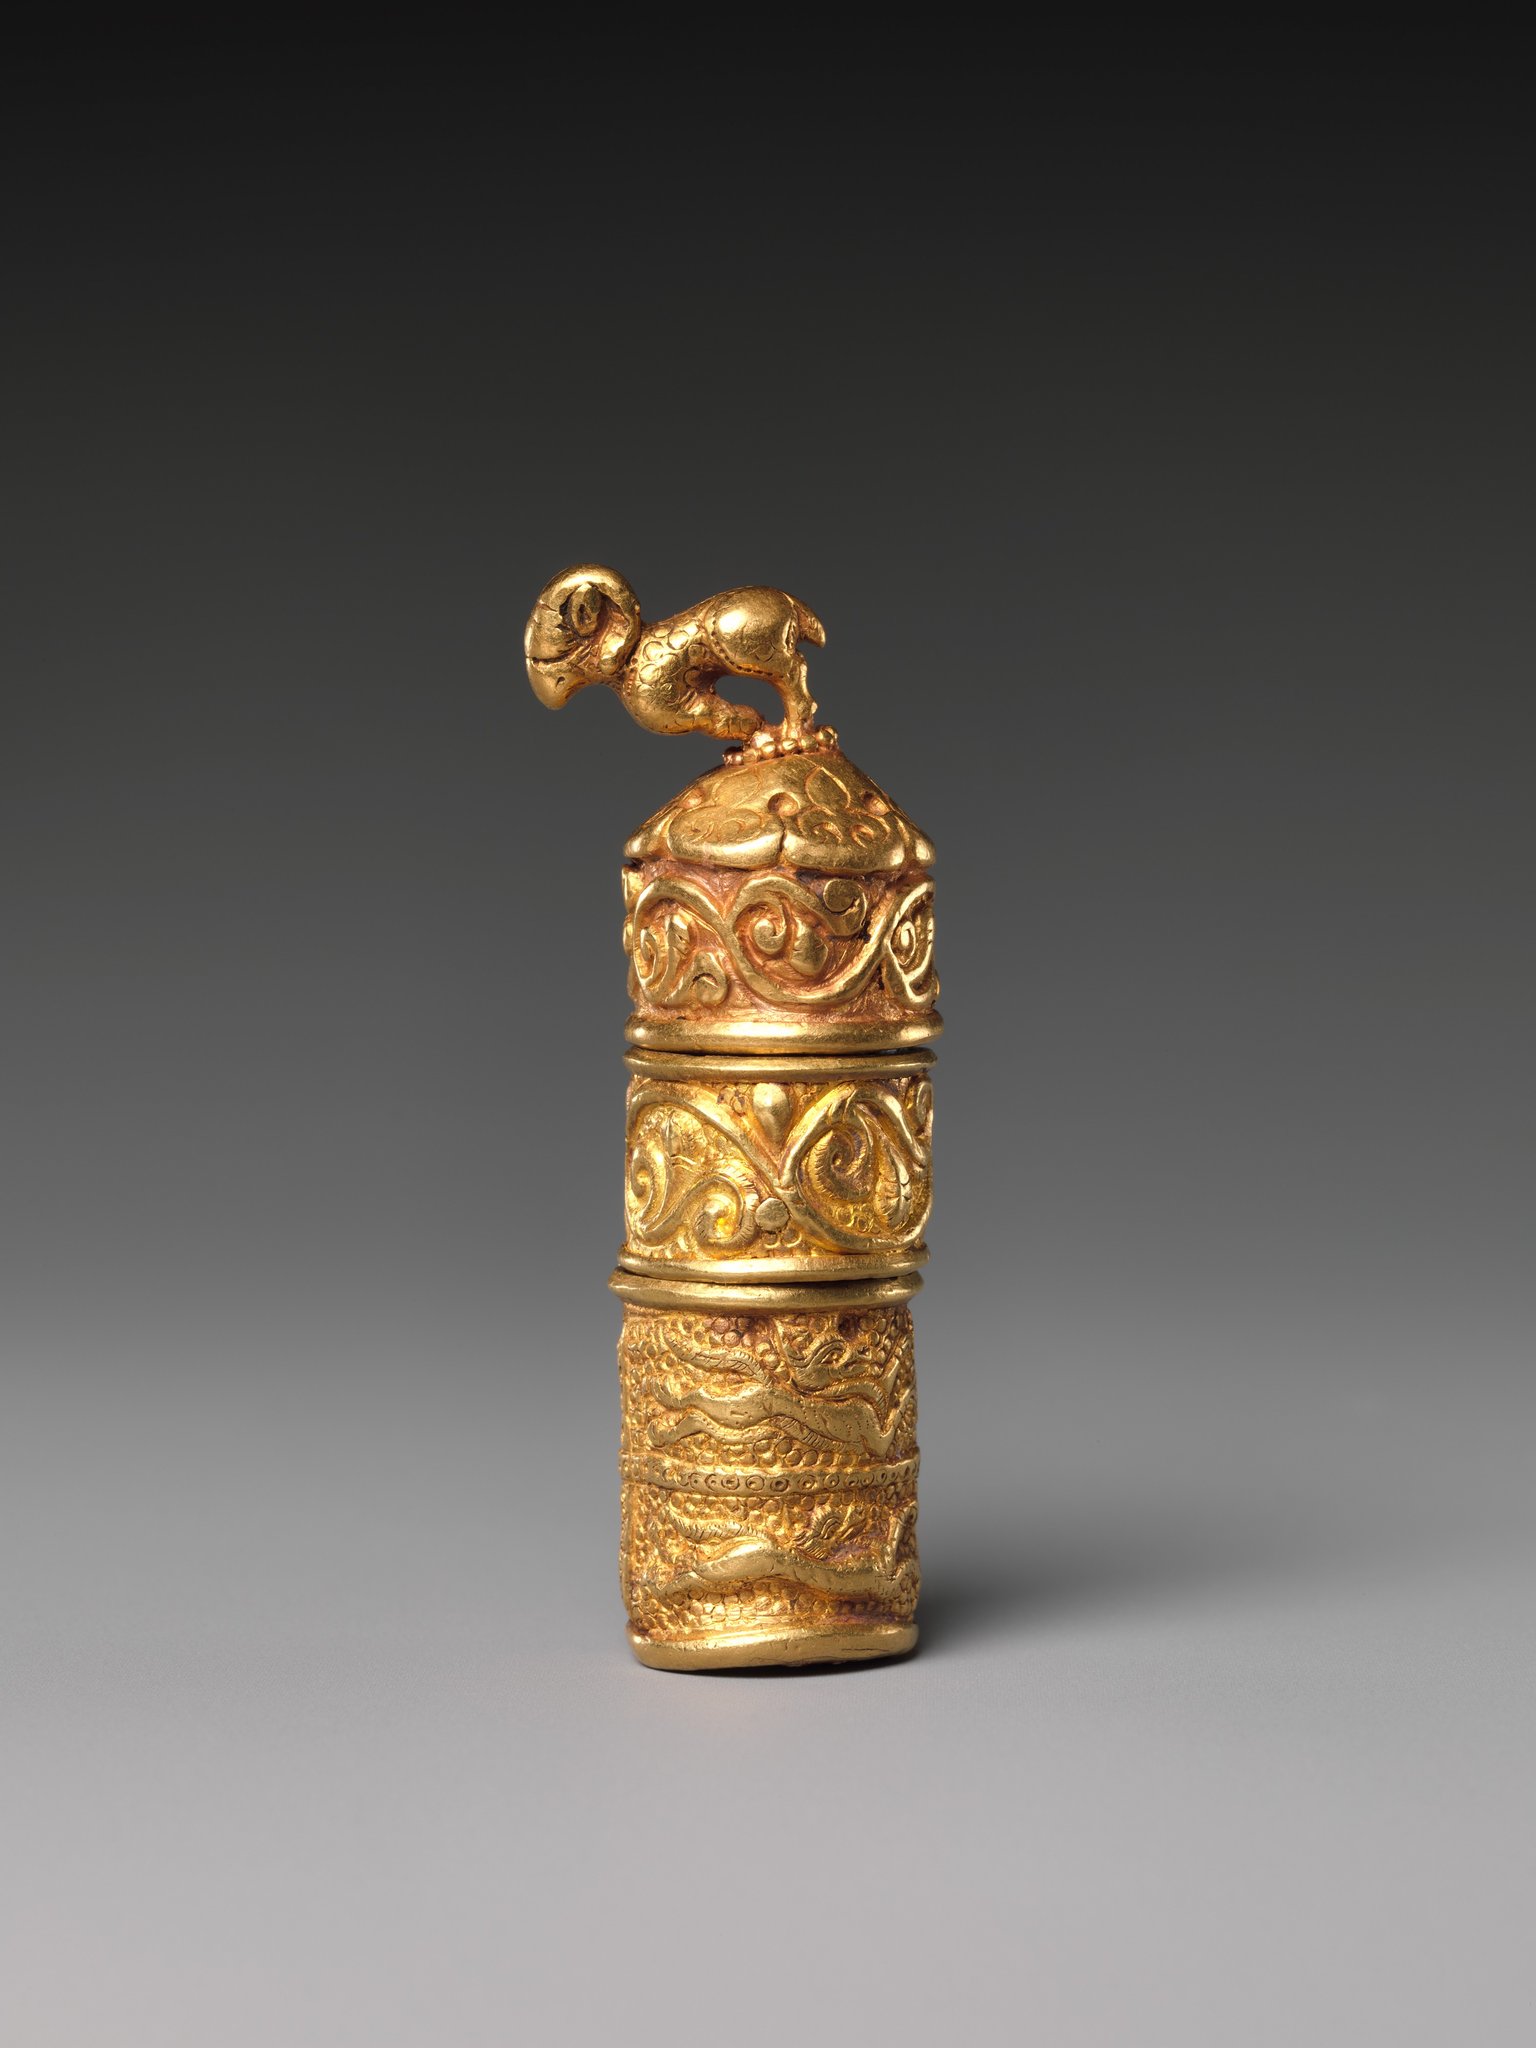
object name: amulet case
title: Amulet Case Surmounted by a Ram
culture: chinese or central asian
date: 601-900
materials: gold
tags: rams